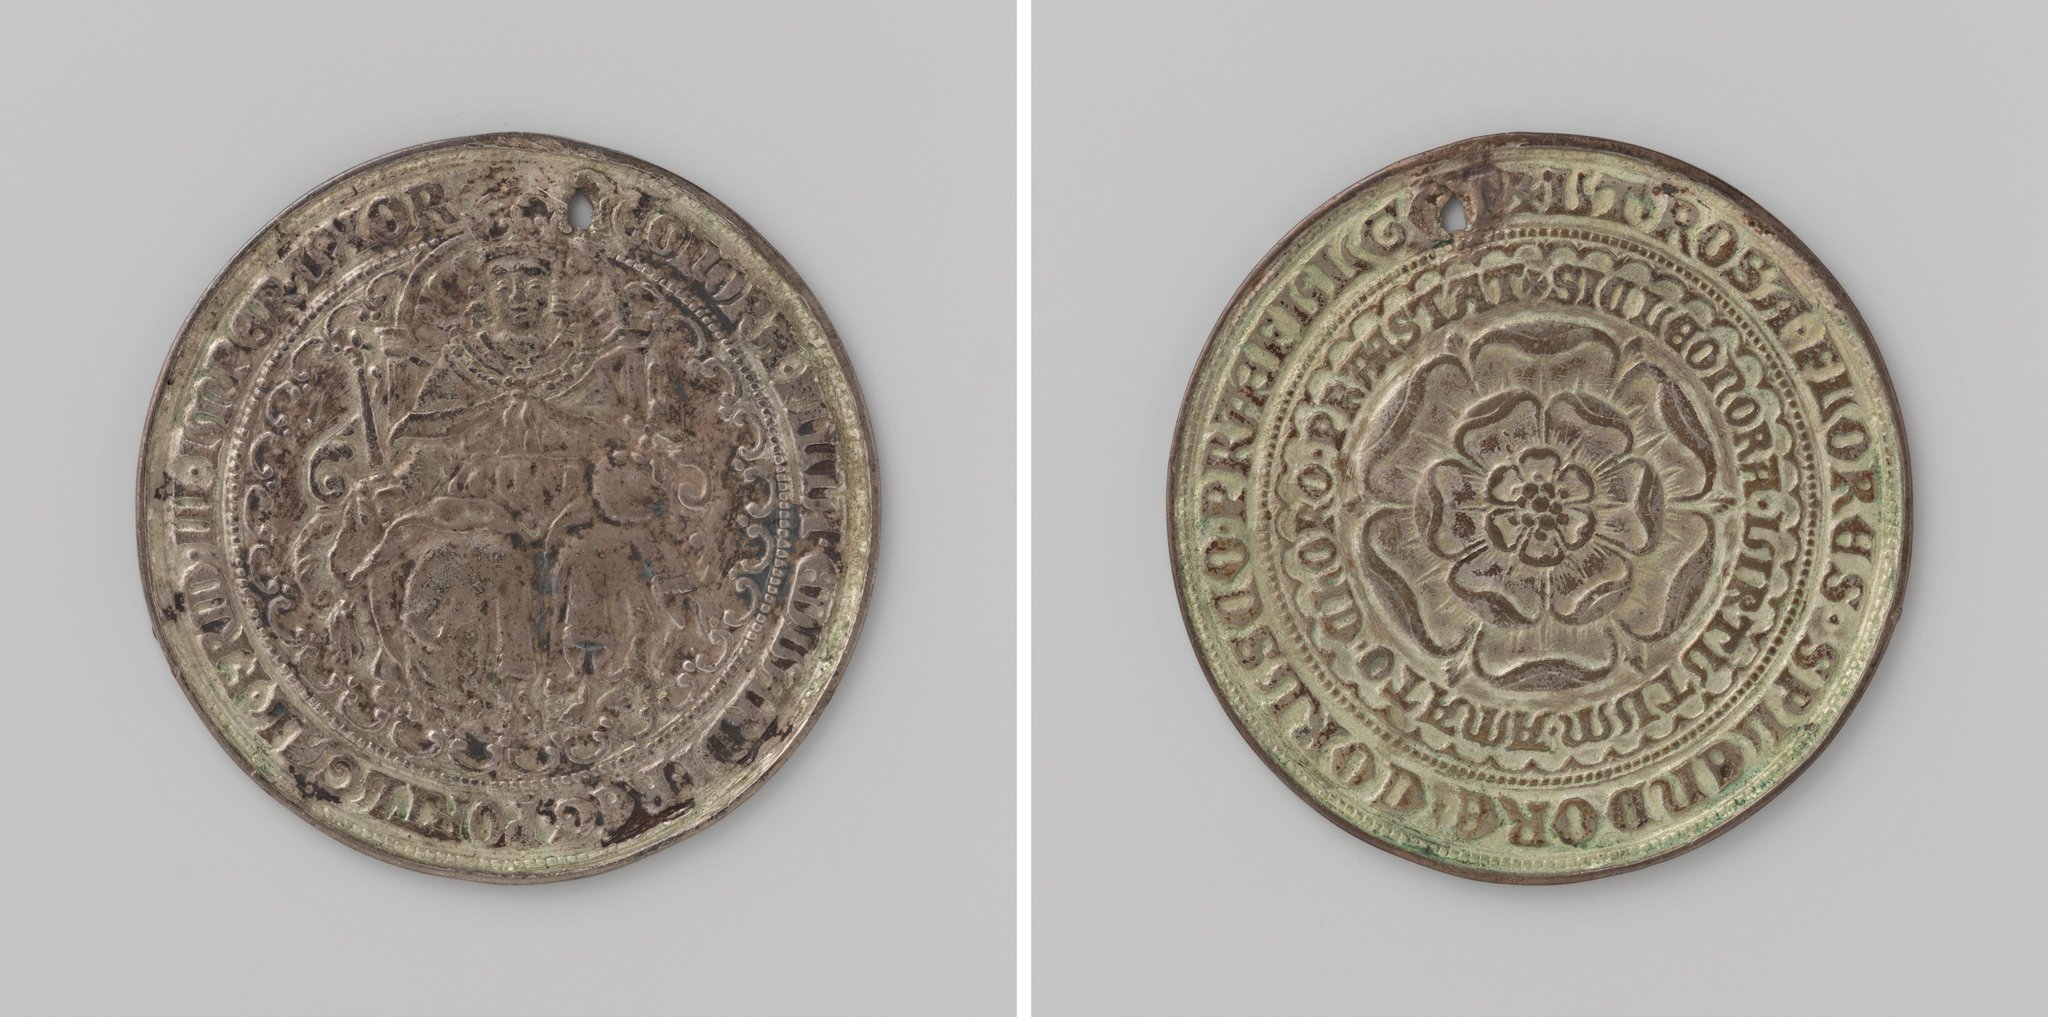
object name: copy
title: Huwelijk van Eleonora, dochter van koning Eduard van Portugal met Frederik III, Duits keizer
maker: Anonymous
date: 1452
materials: bronze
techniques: casting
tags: innsbruck, linz, keizer, frederik iii van habsburg (keizer van het heilige roomse rijk), portugal, wiener neustadt, keizerin, eleonora helena van portugal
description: Bronzen penning met gat erin. Voorzijde: vrouw met kroon, rijksappel en scepter zittend op troon binnen omschrift binnen omschrift. Keerzijde: roos binnen tweeregelig omschrift.